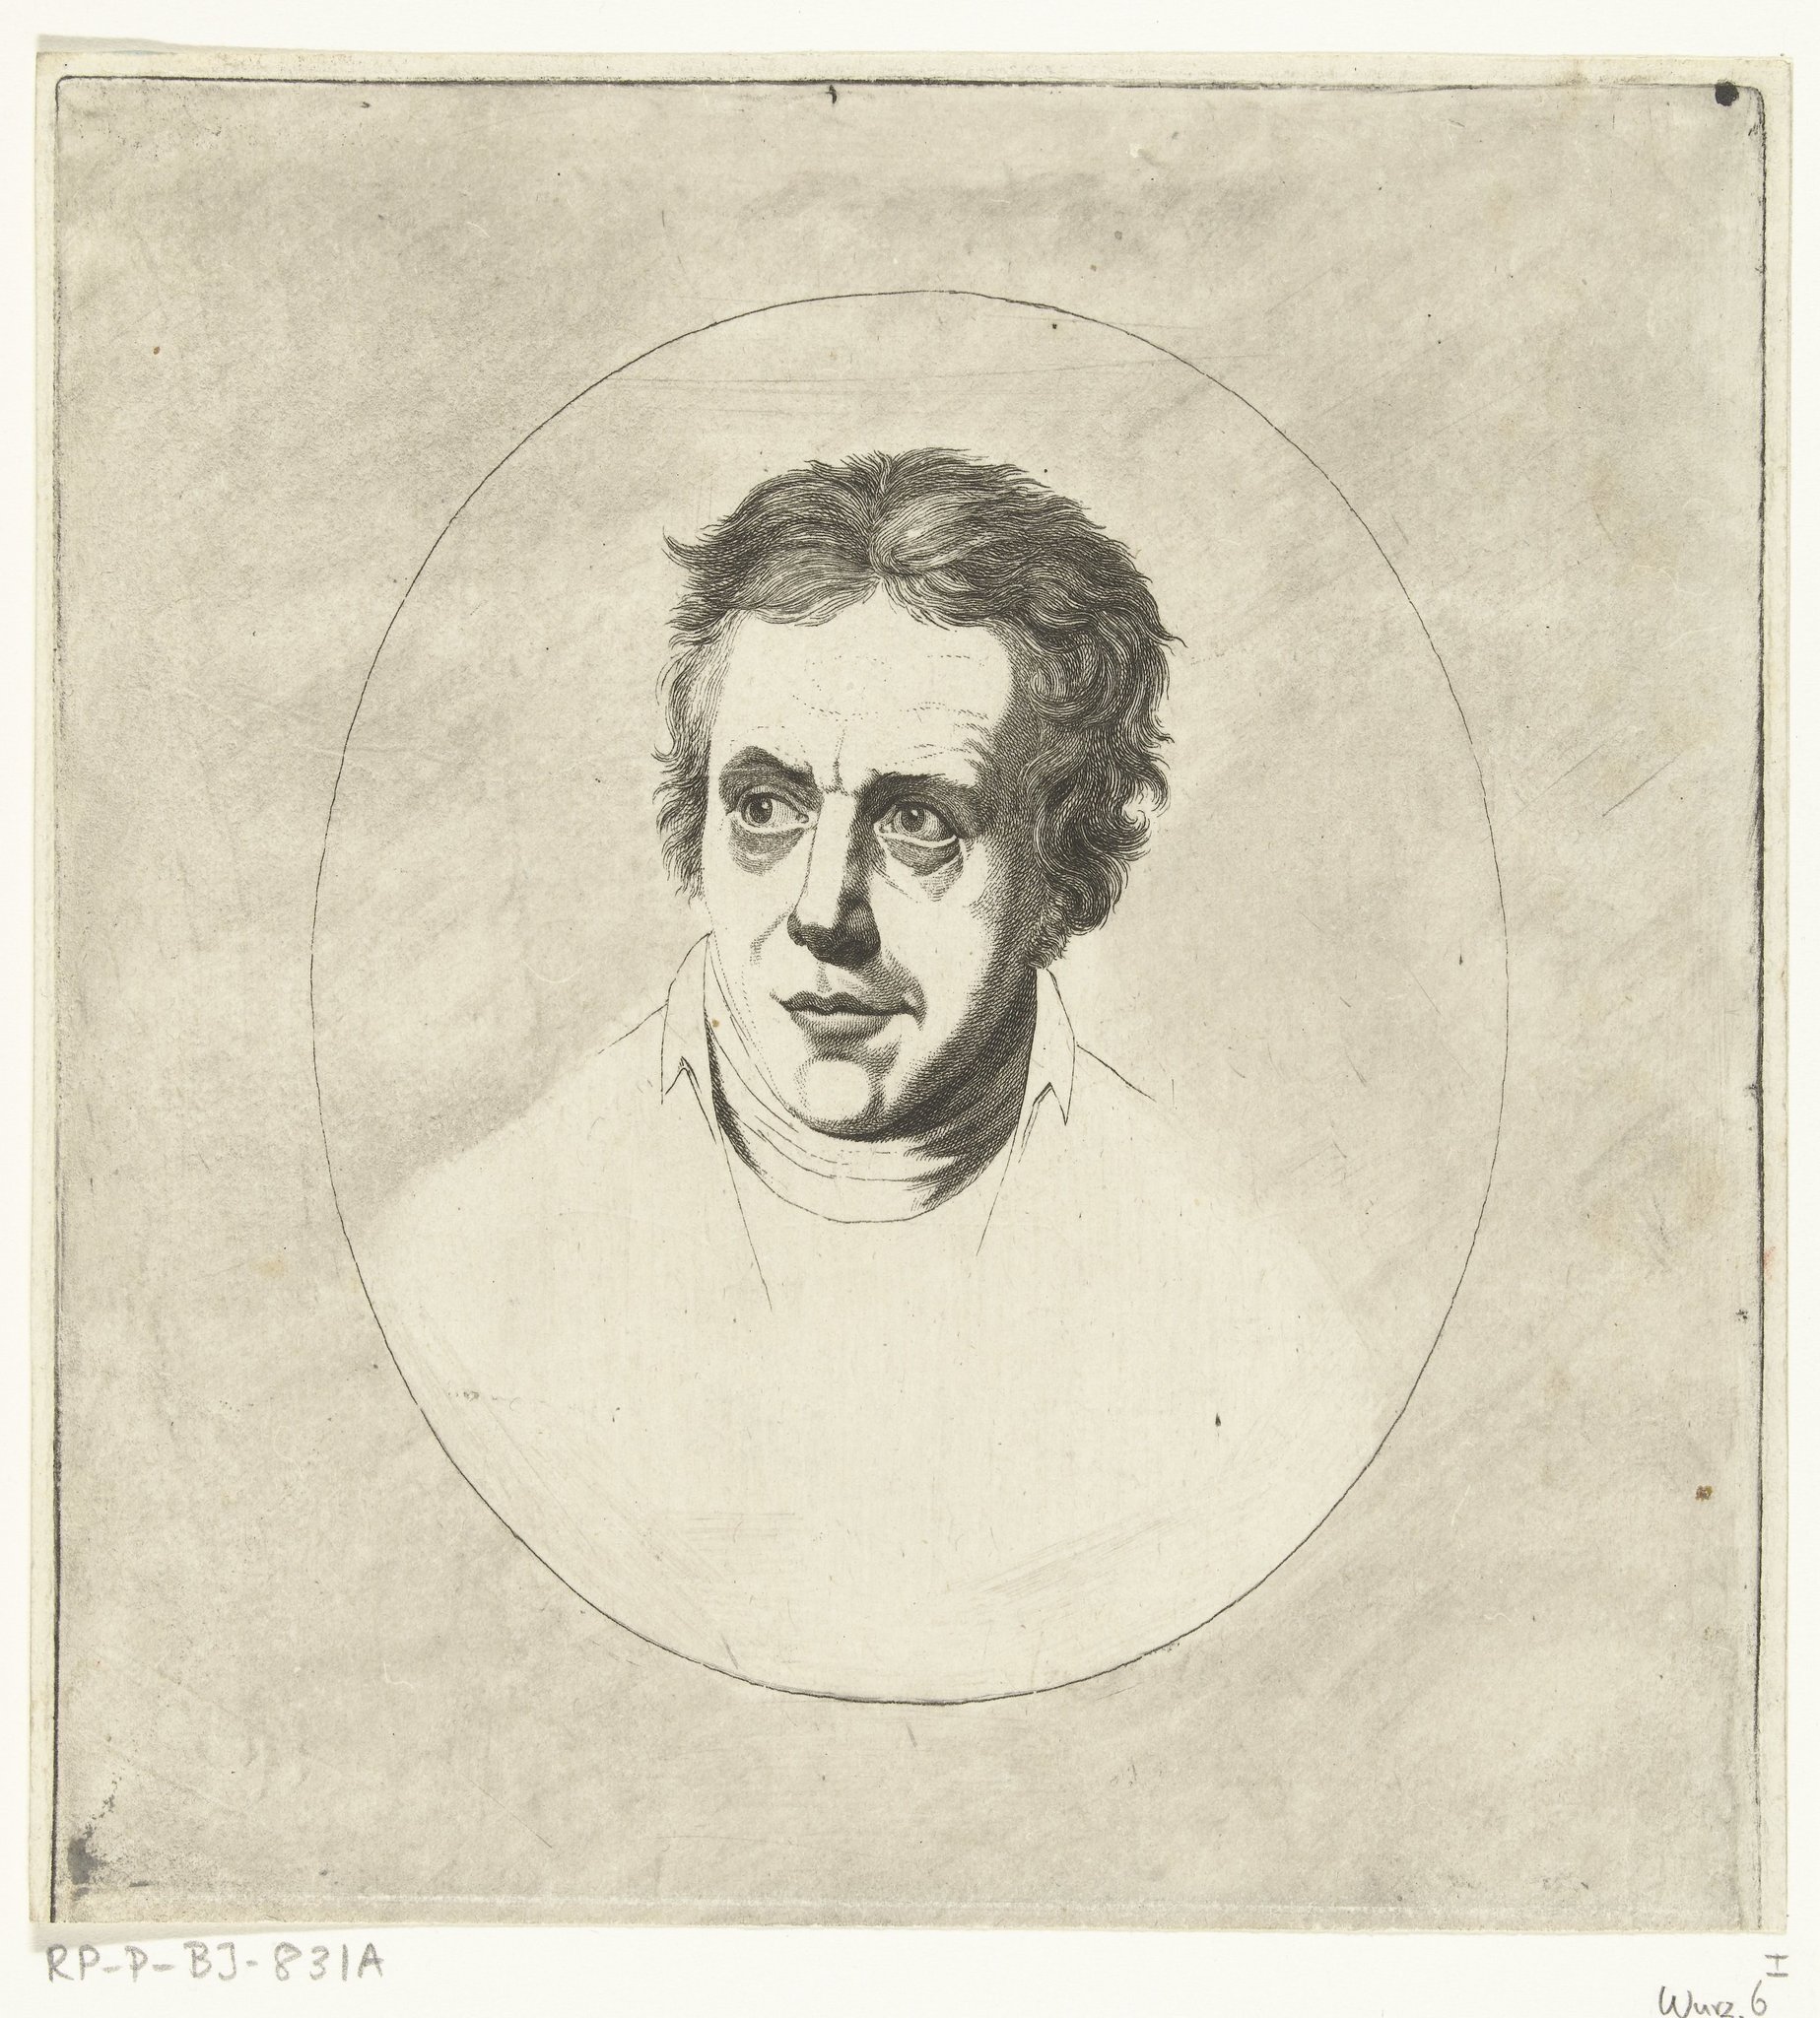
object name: print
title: Portret van Dirk Langendijk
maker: joannes bemme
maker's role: print maker, printer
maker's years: 1775-1841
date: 1805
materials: charcoal, paper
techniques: etching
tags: rotterdam, painter, print maker, draughtsman, dirk langendijk, art (+ portrait, self-portrait of artist)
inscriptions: collector's mark: Lugt 2228